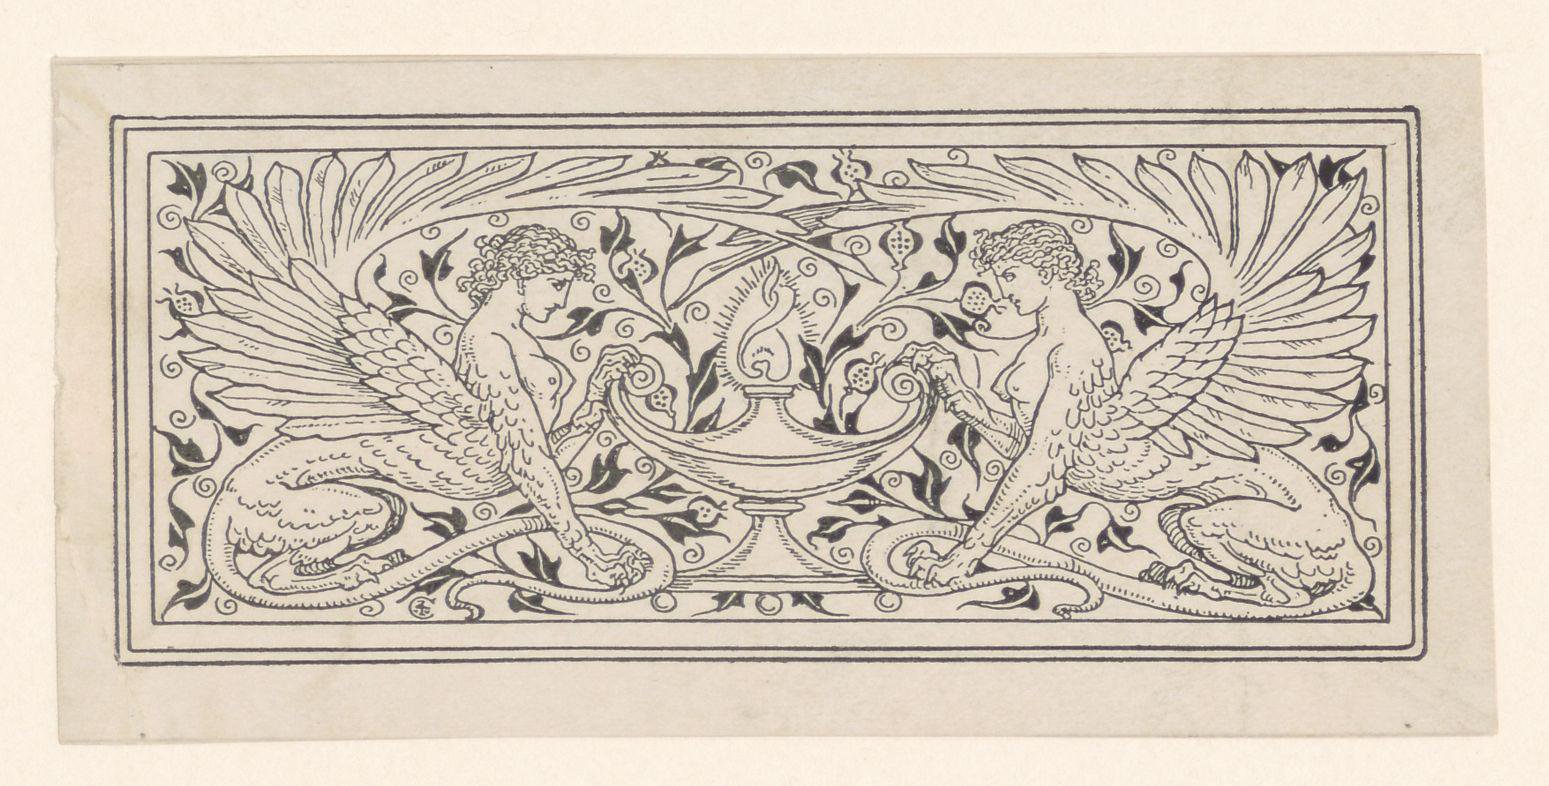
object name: print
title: Twee sfinxen bij een lamp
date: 1887-1893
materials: paper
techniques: engraving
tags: sphinx (lion/woman); 'sfinge' (ripa) - aa - female human figure, lighting; lamps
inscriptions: collector's mark: Lugt 2228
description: De prent is gebruikt in: Crane, Walter. The claims of decorative art. Londen: Lawrence & Bullen, 1892.